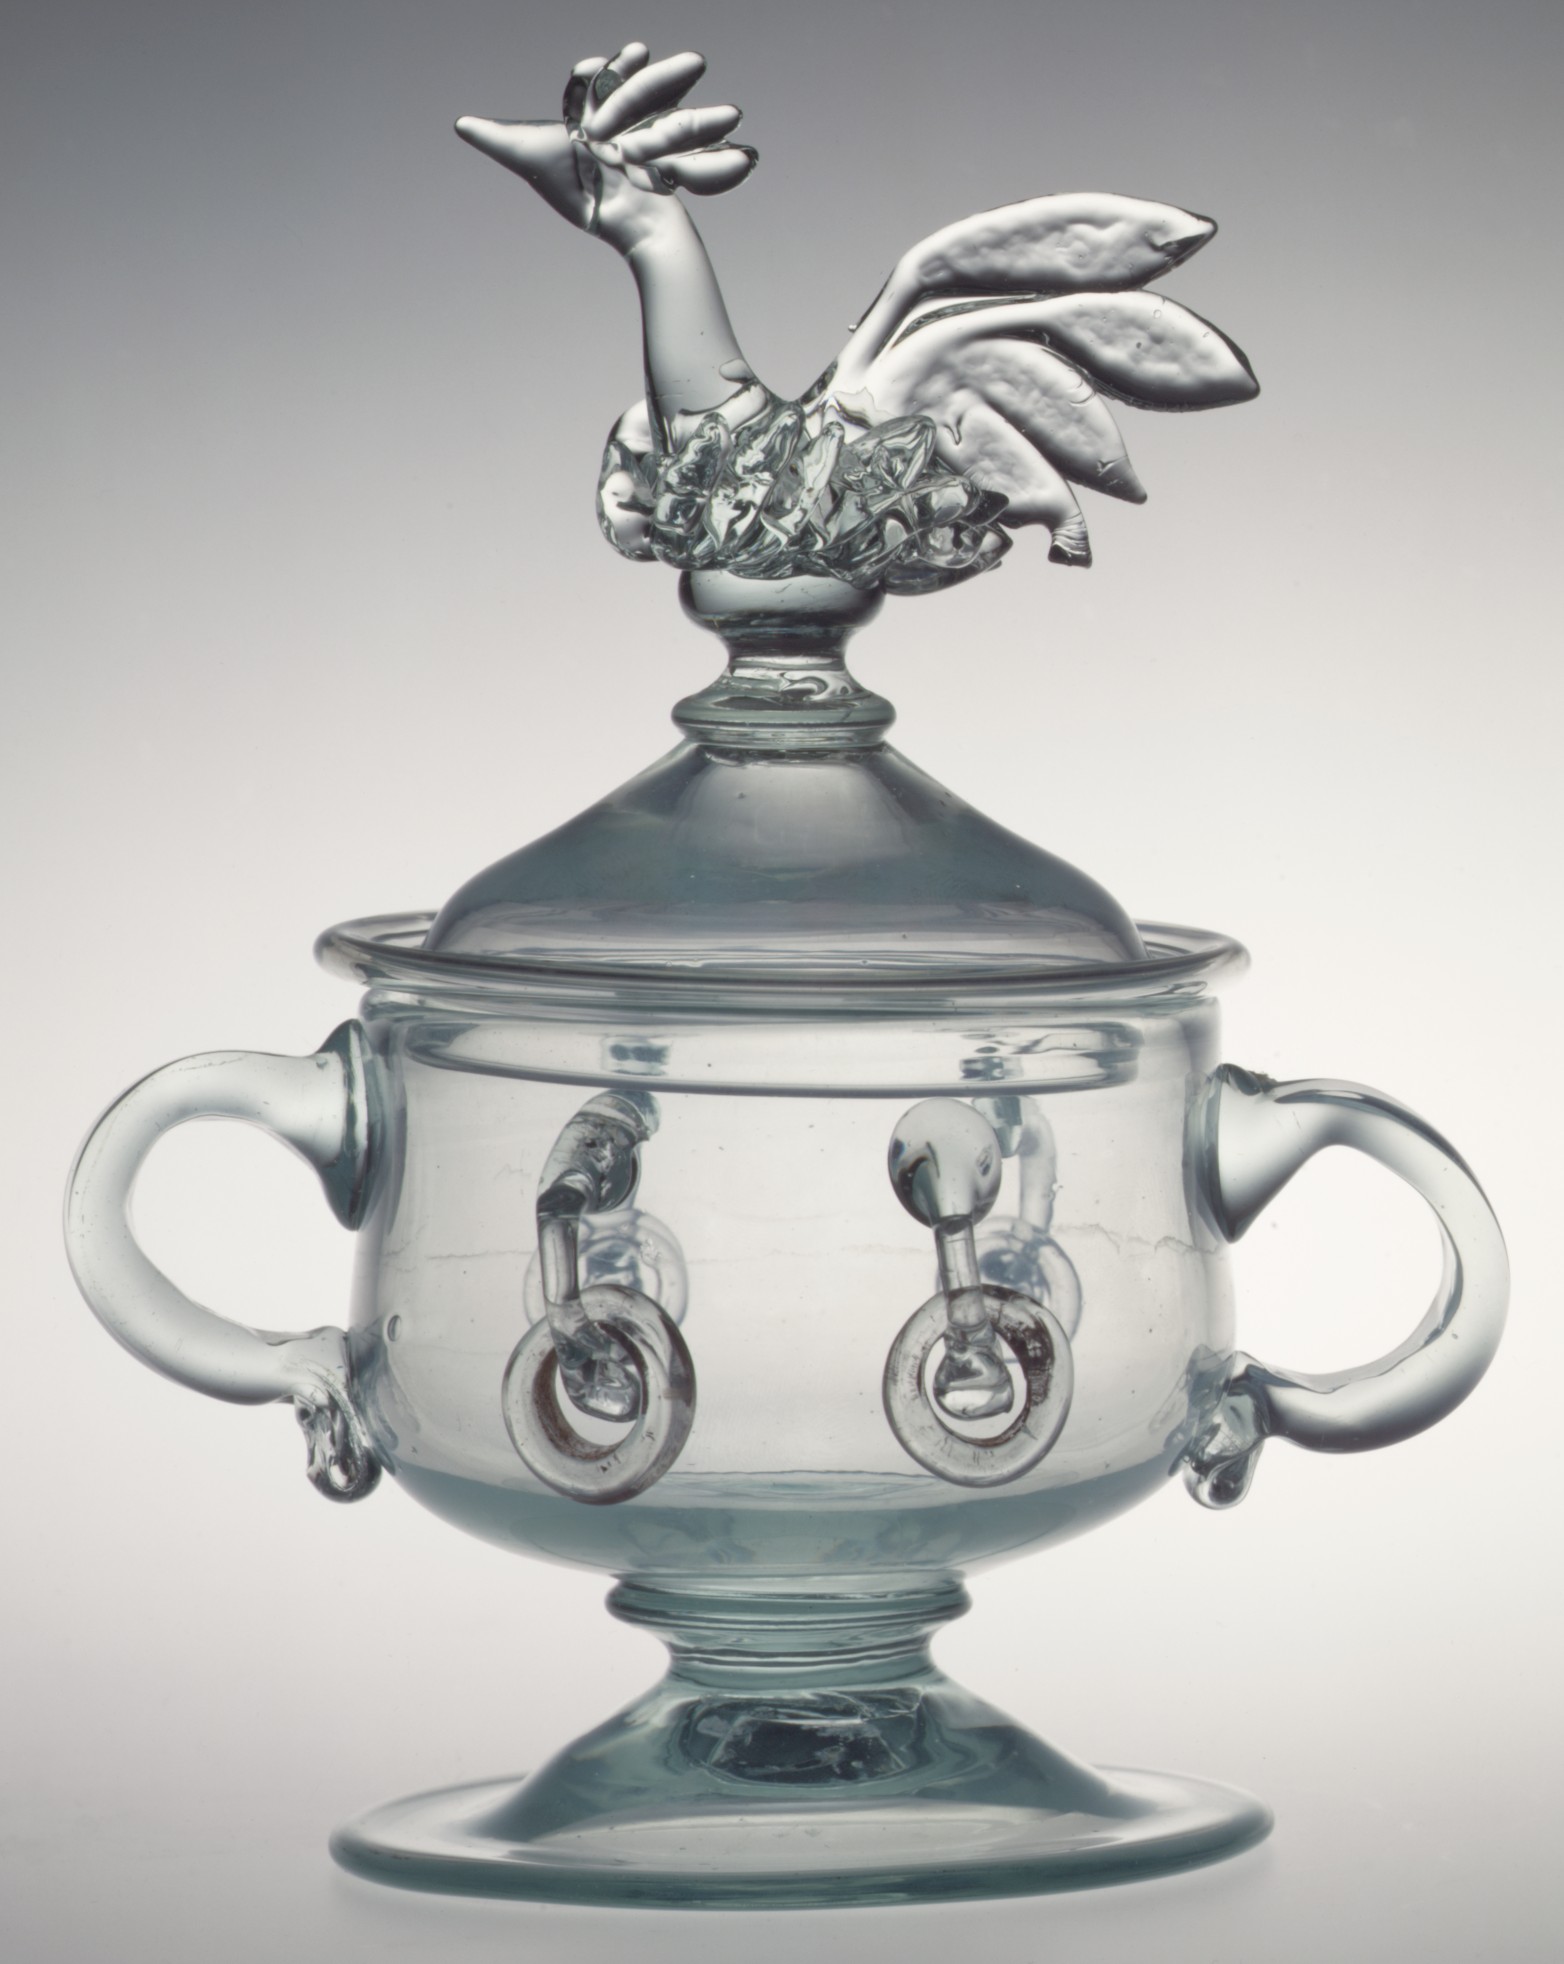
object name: honey bowl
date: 1701-1800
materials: glass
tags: birds